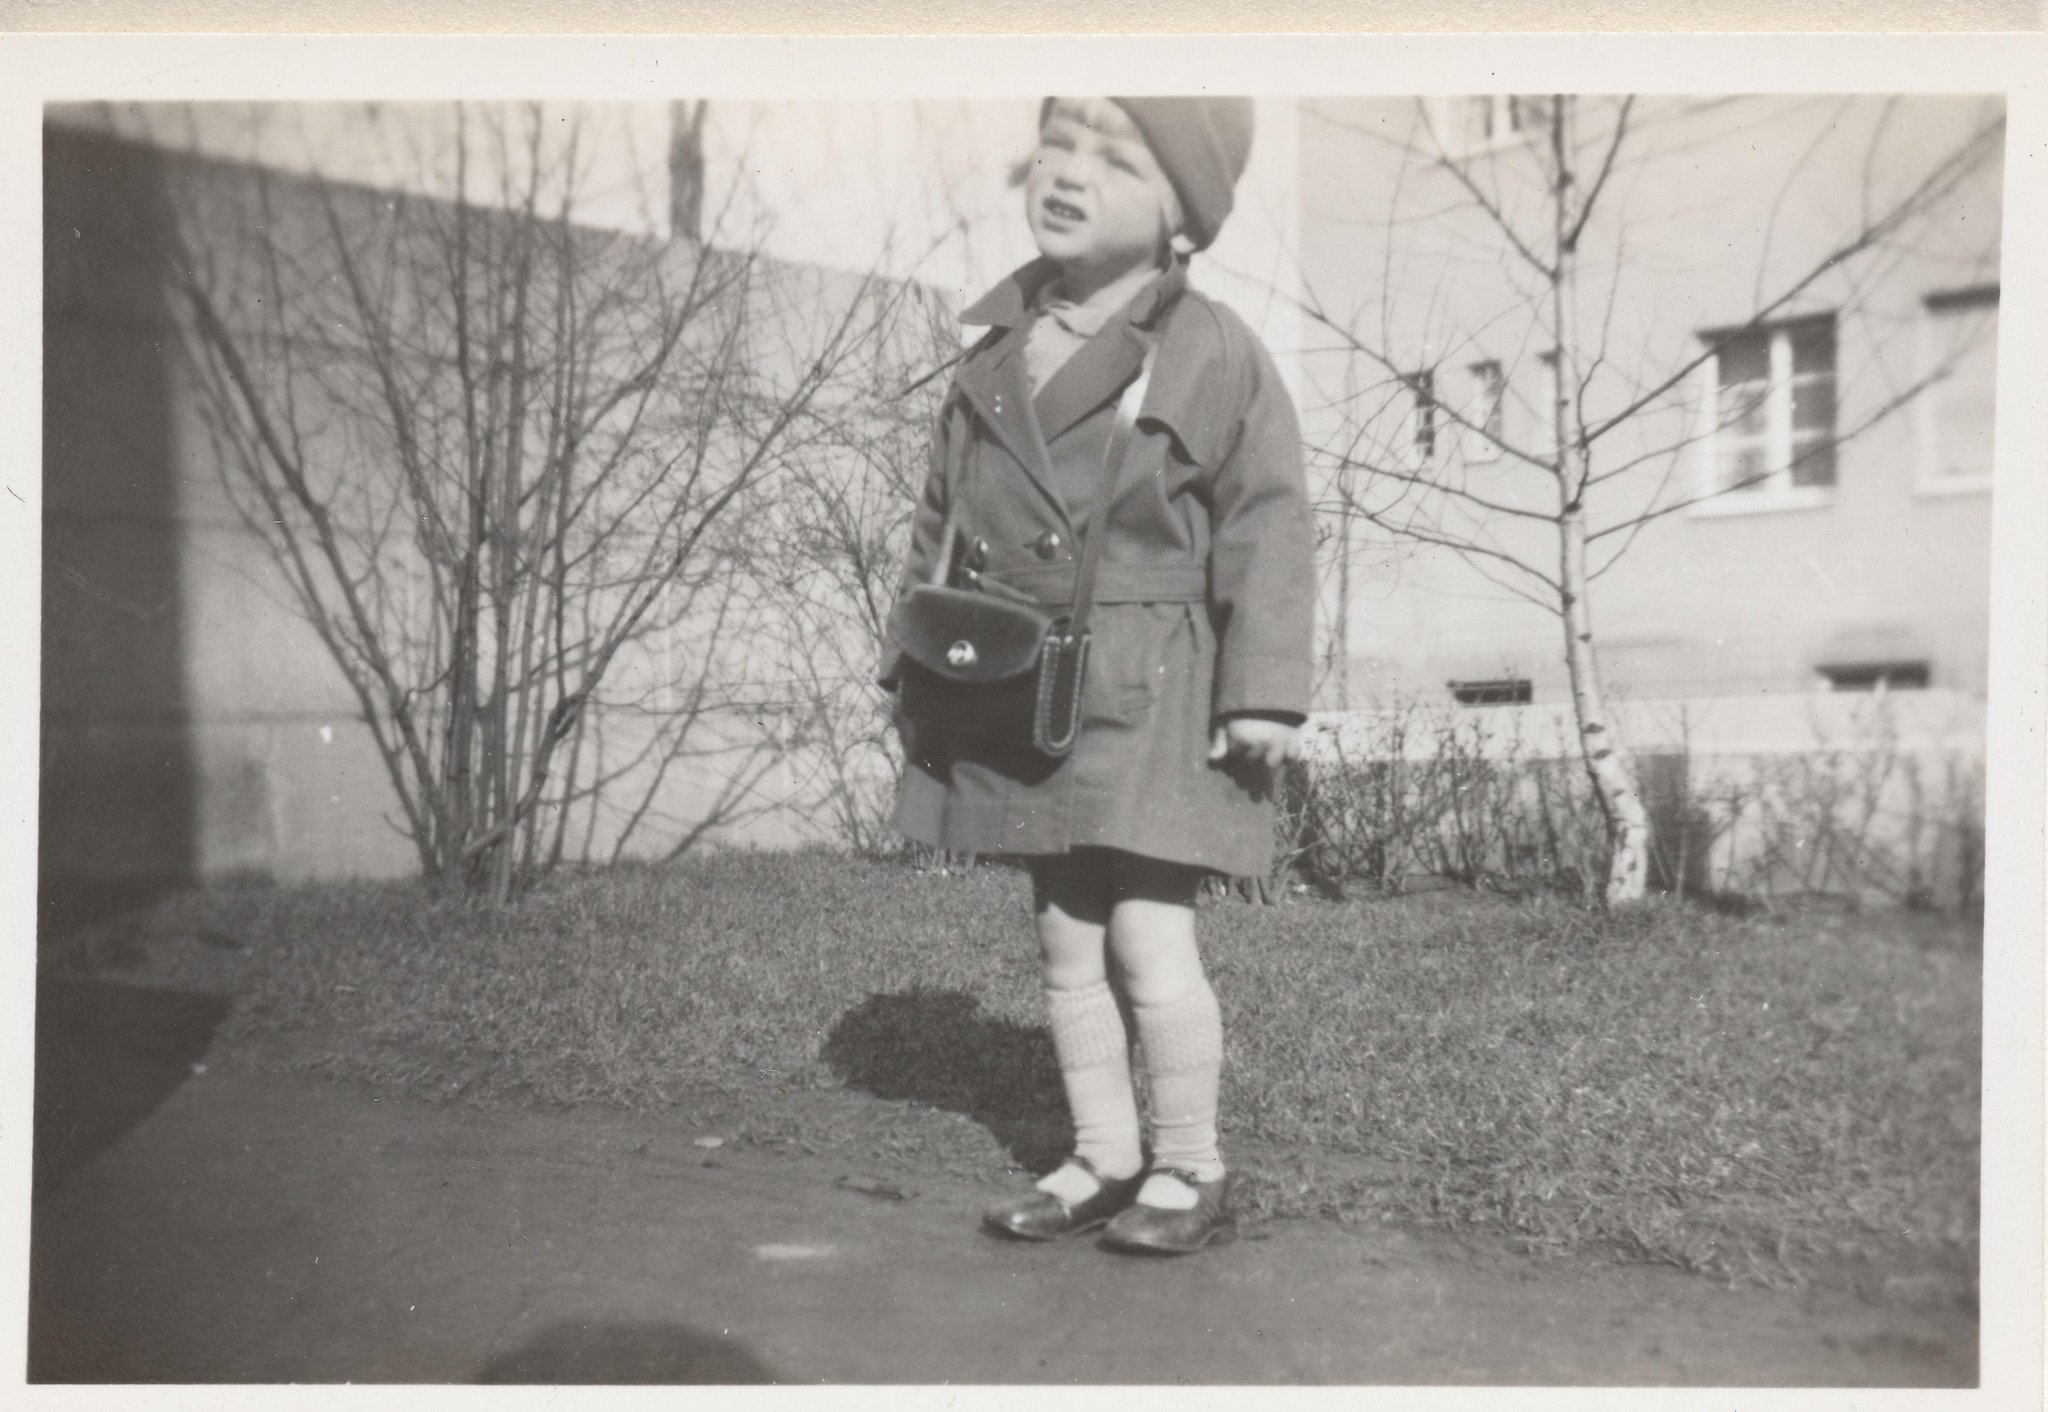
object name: photograph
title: Kind in winterjas staand in een tuin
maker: Anonymous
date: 1920-1940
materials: paper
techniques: gelatin silver print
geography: germany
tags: child between toddler and youth (of undetermined sex), germany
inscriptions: factory mark: ‘Agfa Lupex’